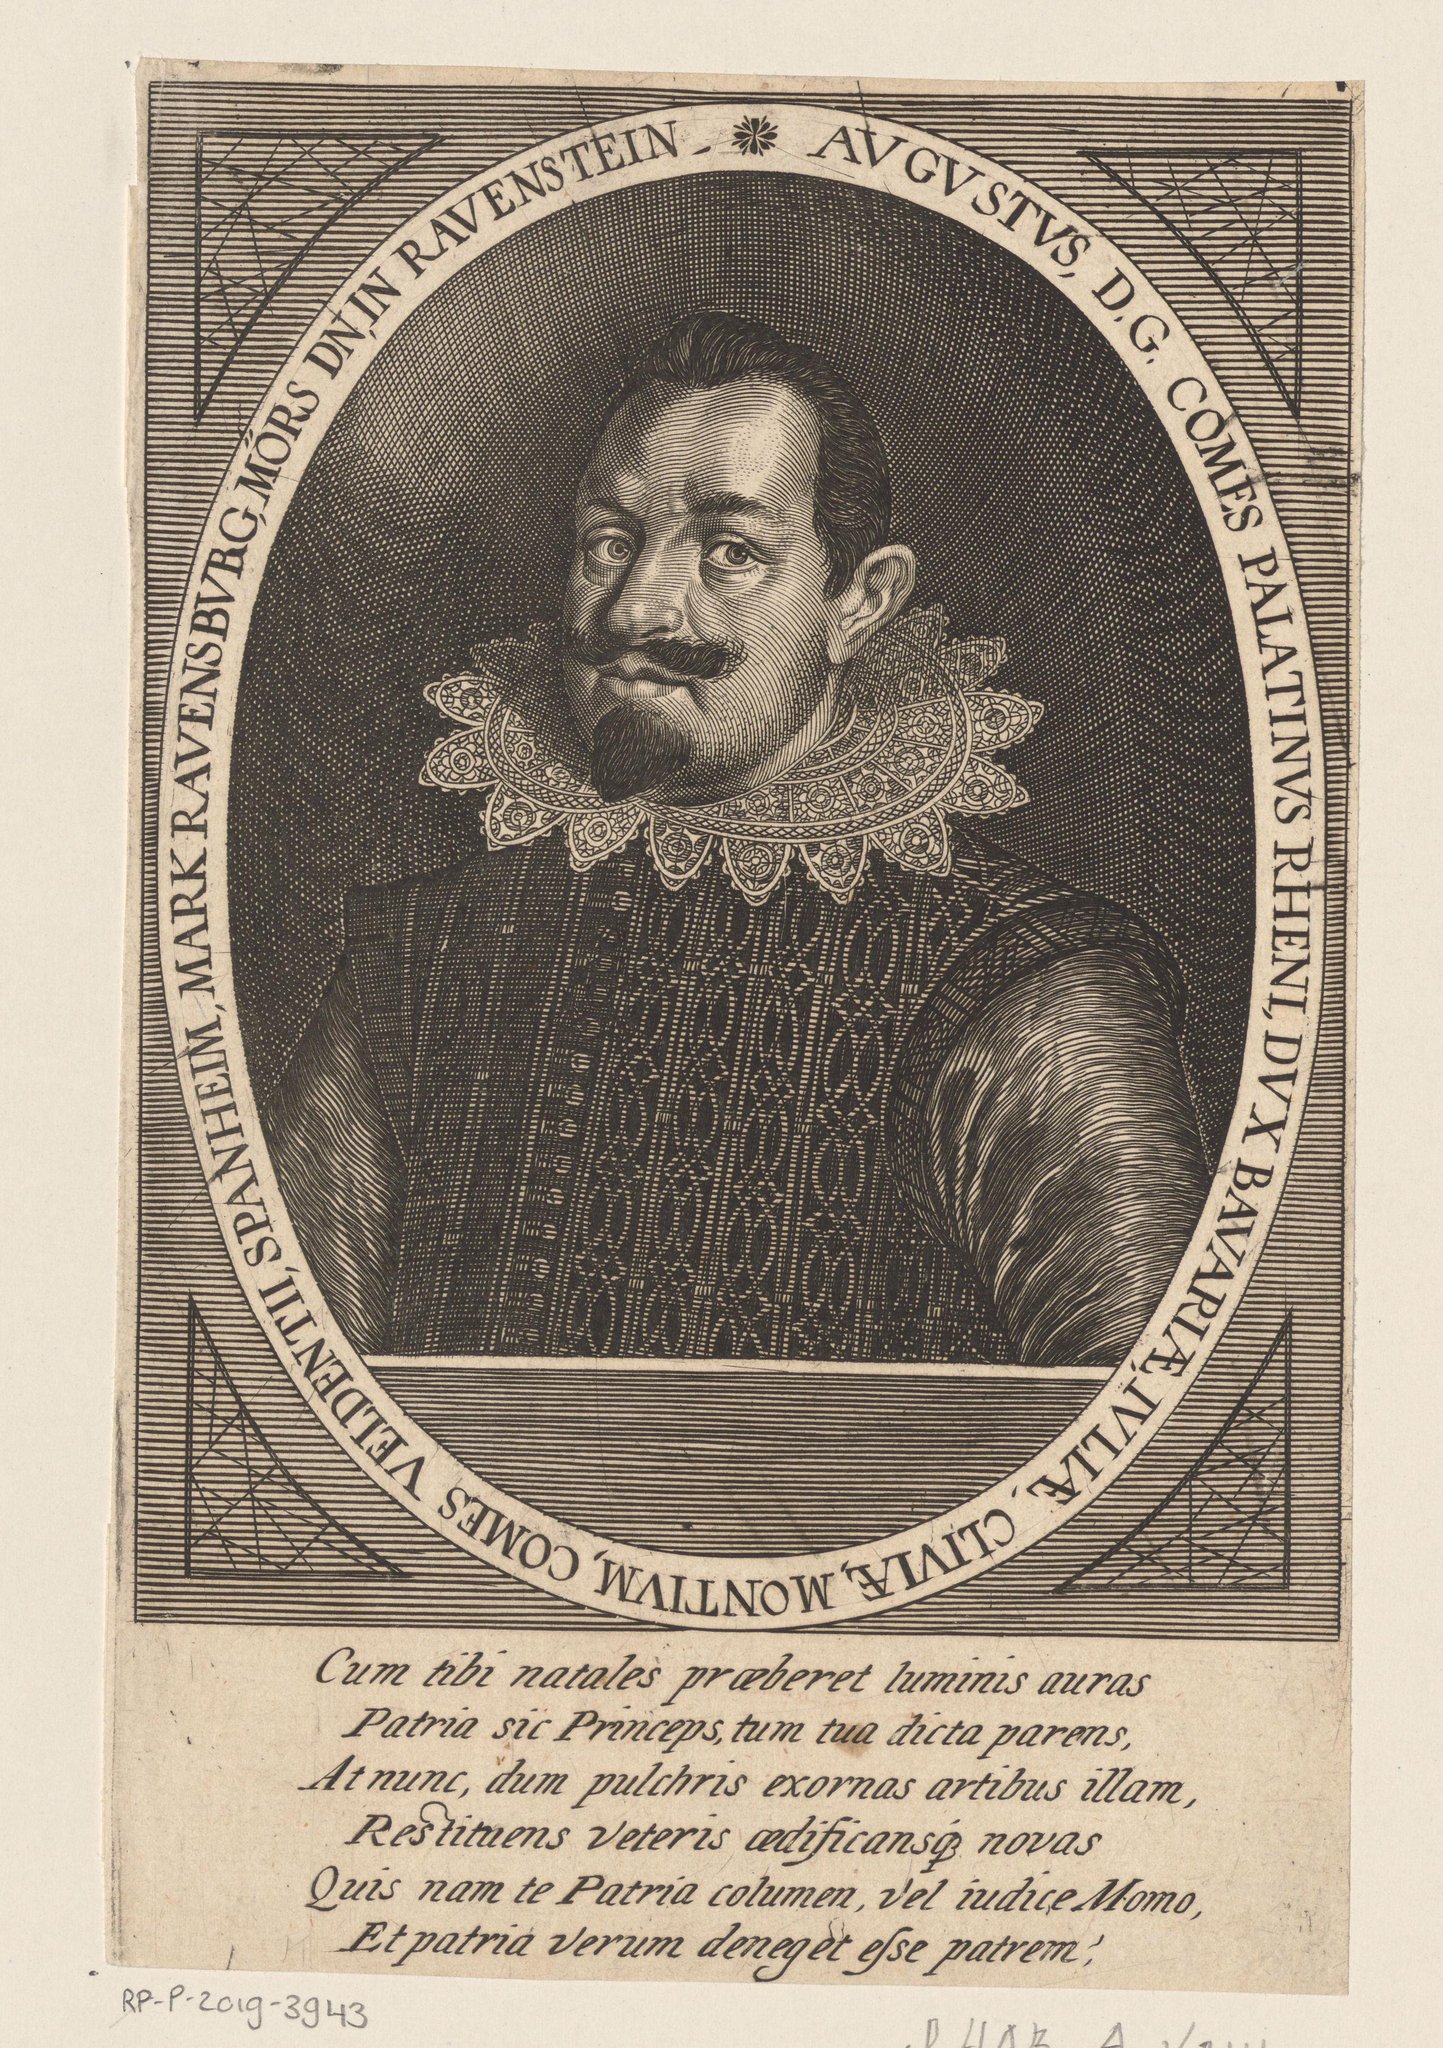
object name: print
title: Portret van August van Palts-Sulzbach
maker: Anonymous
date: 1614-1649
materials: paper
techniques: etching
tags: historical persons